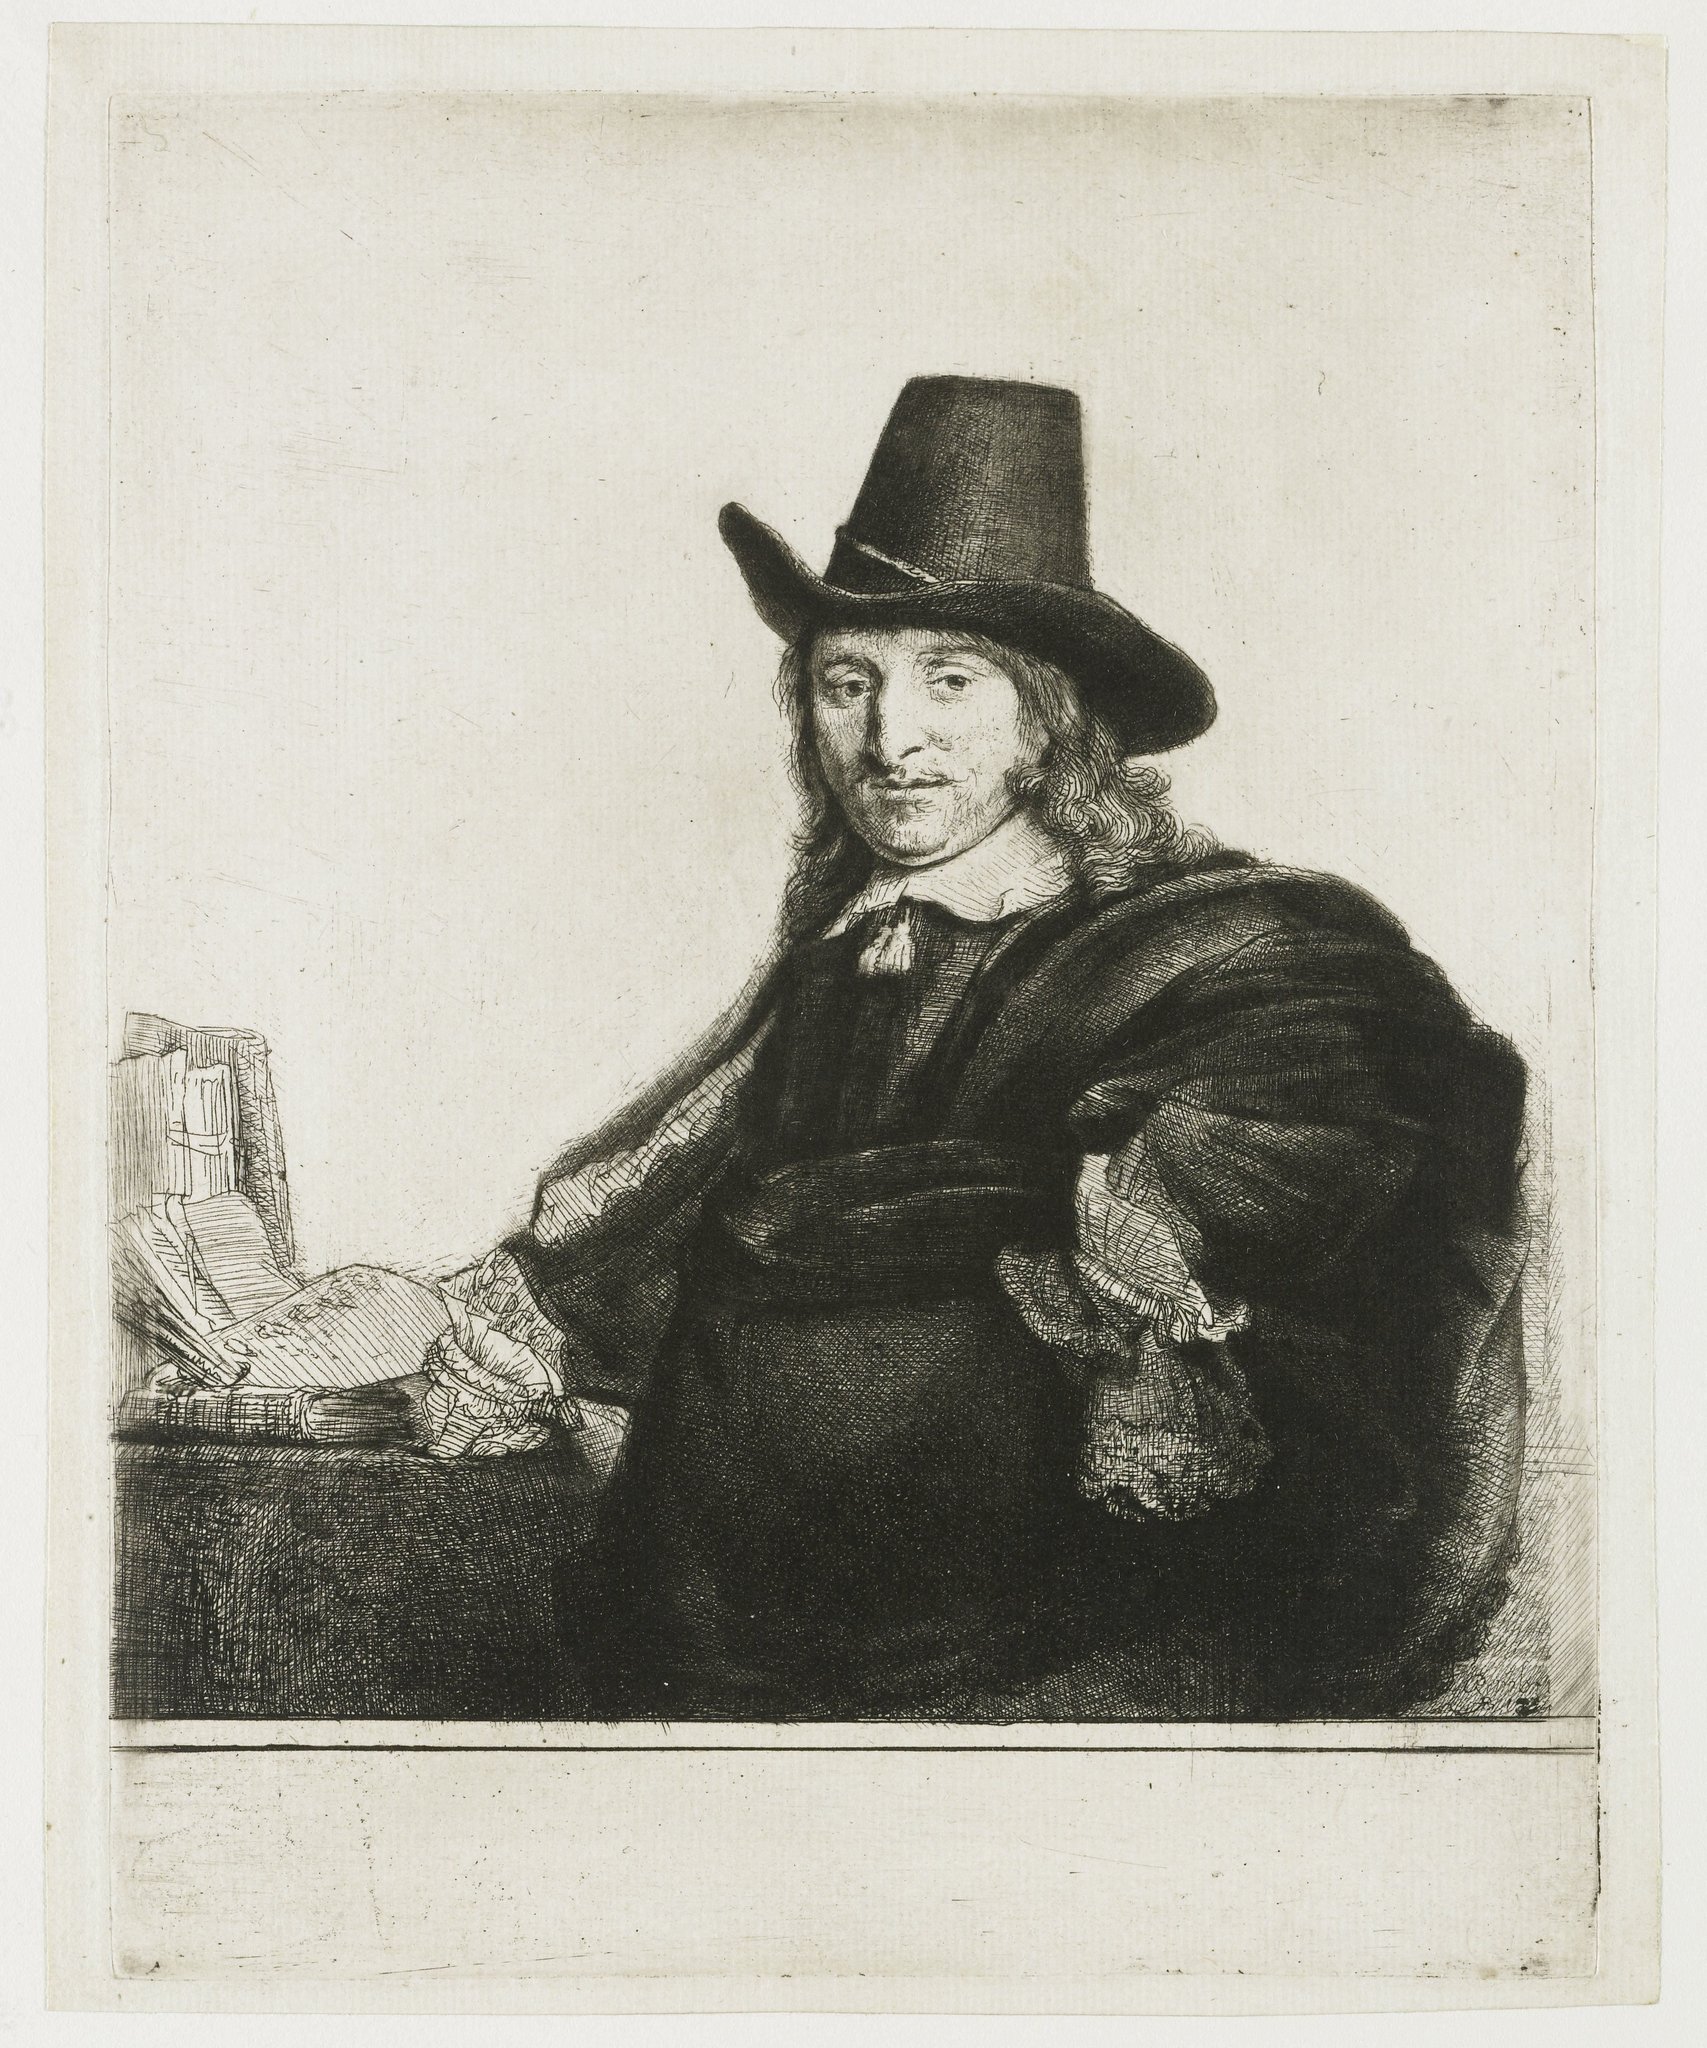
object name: print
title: Jan Asselijn, painter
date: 1647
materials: paper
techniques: drypoint, etching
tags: amsterdam, jan asselijn, portrait, self-portrait of painter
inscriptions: collector's mark: Lugt 699, collector's mark: Lugt 240, signature and date: ‘Rembr / f 16’